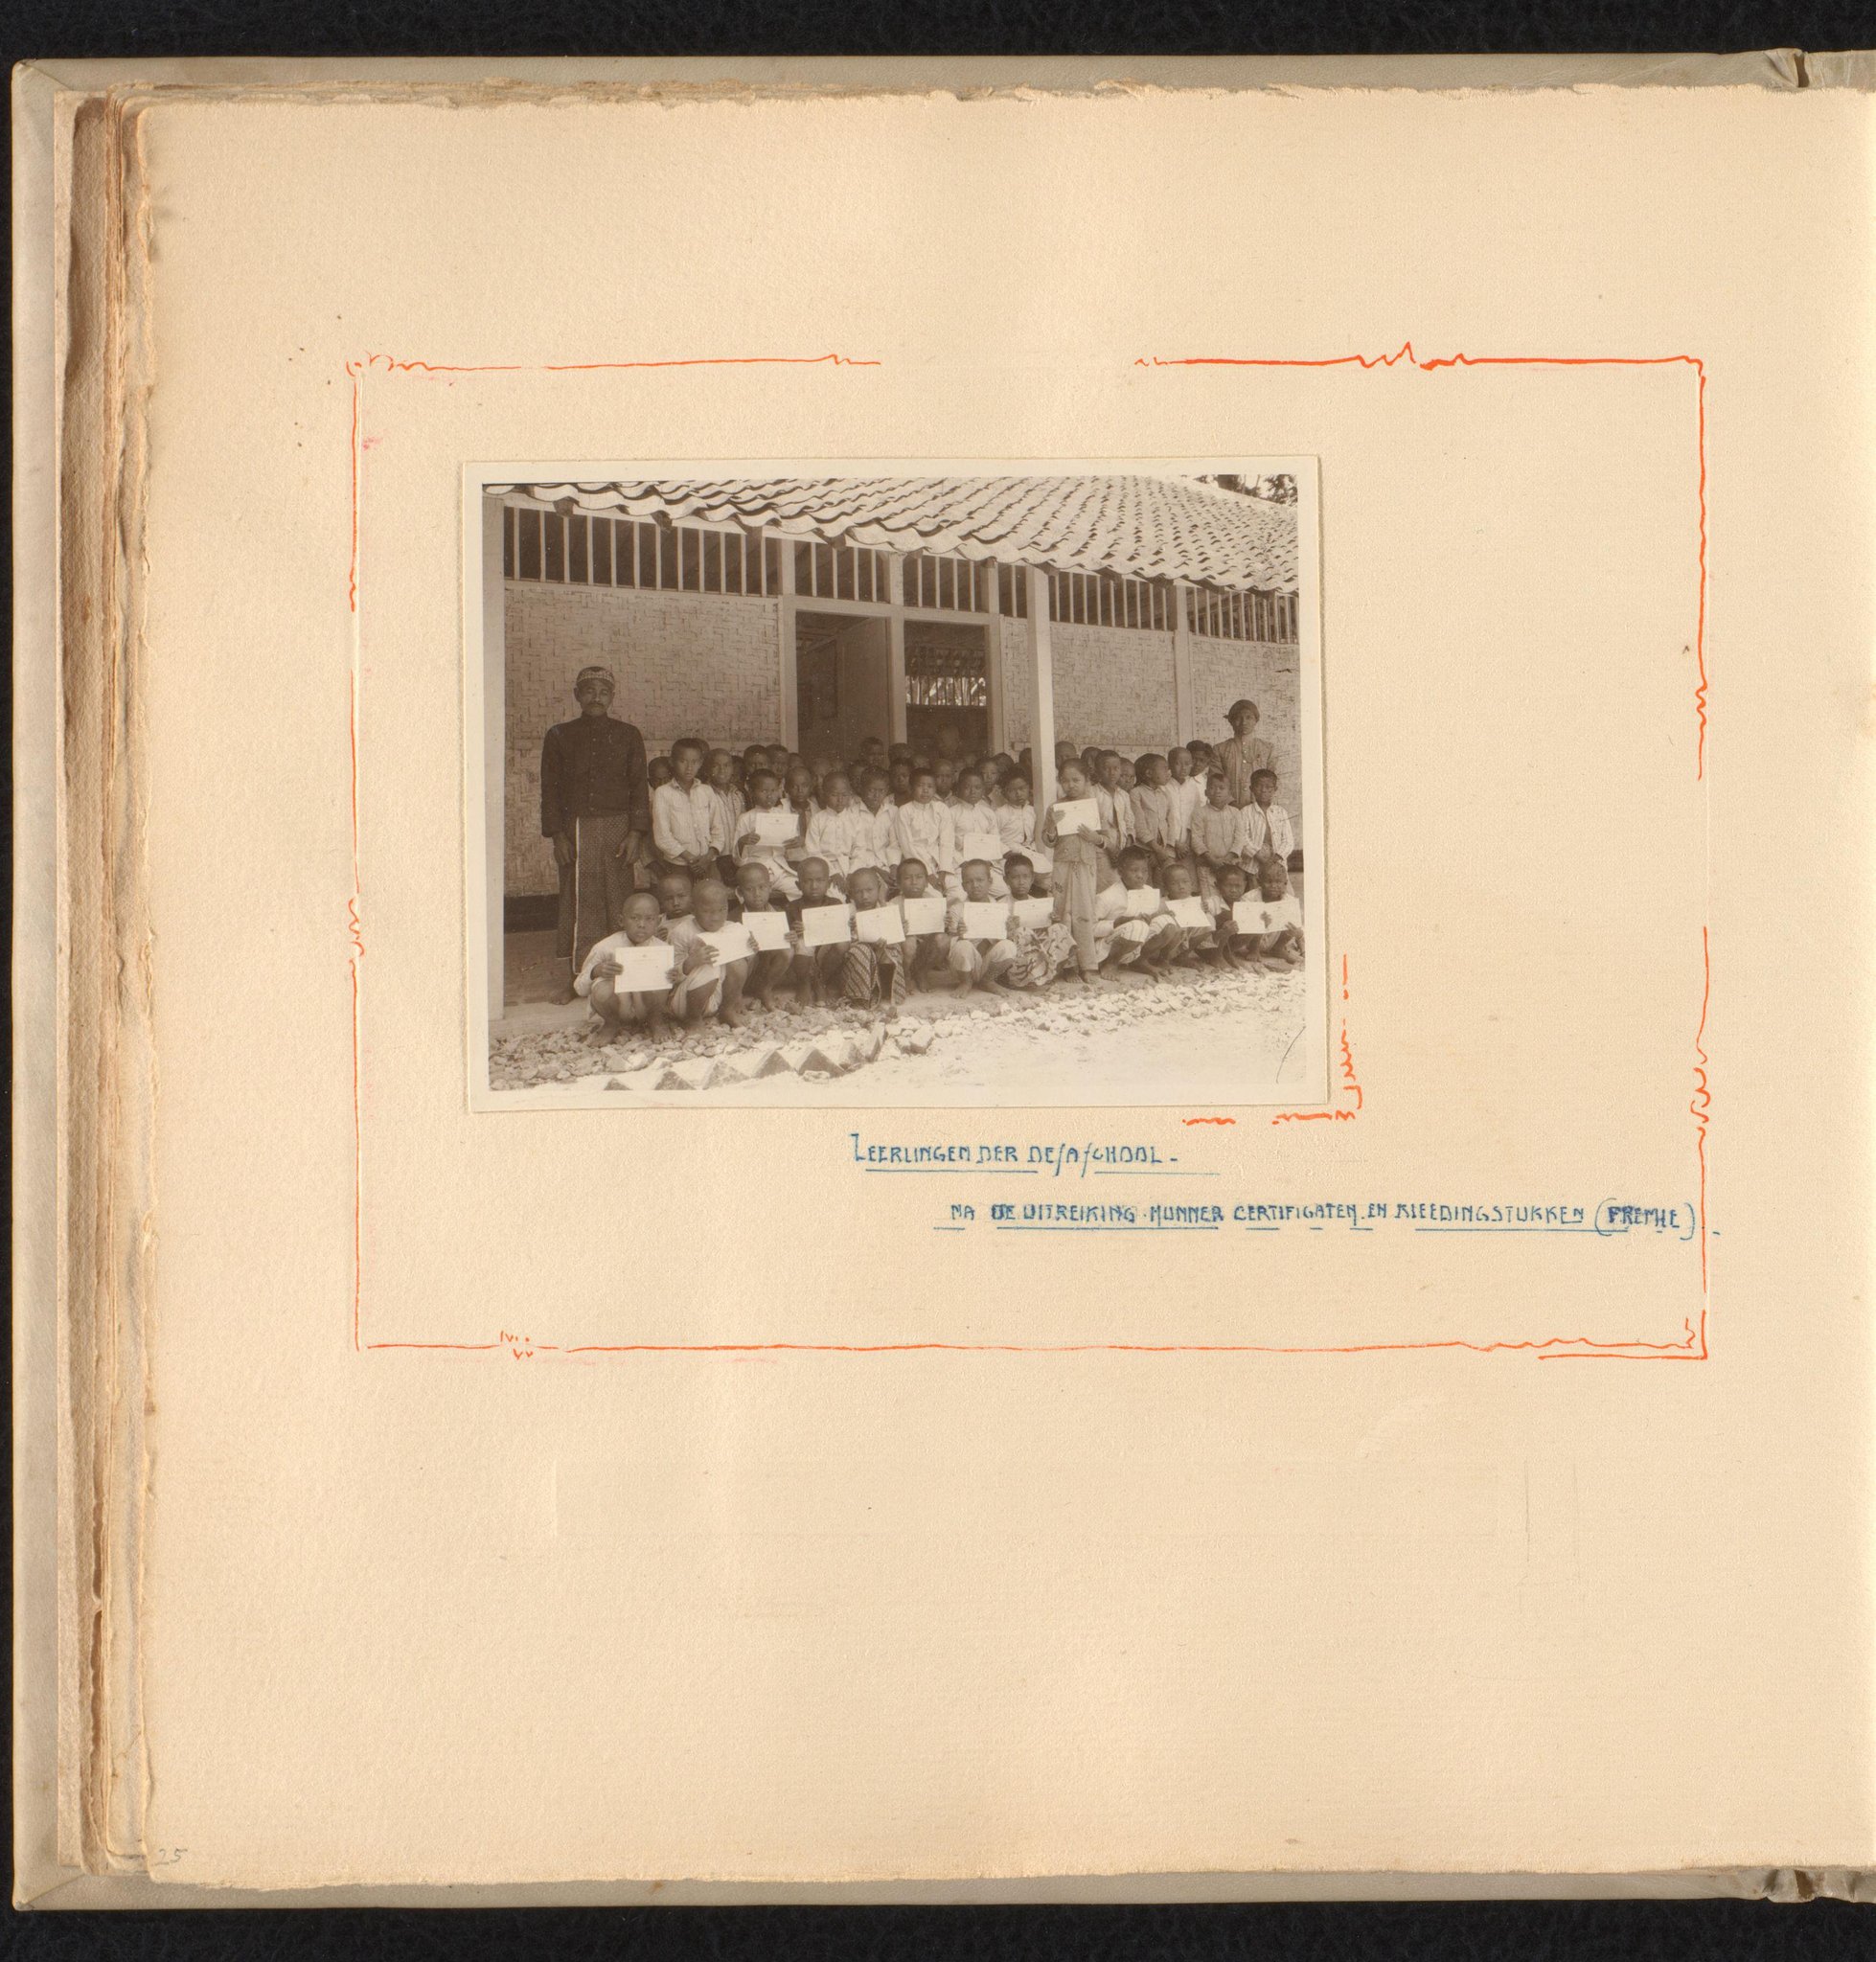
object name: album leaf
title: Leerlingen van een dorpsschool in Grobogan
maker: Anonymous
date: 1910-1928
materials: paper, photographic support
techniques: drawing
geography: grobogan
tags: teacher and pupil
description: Albumblad met een groepsfoto van de leerlinen van een dorpsschool in Grobogan. Het blad is versierd met randwerk om de foto's. Onderdeel van het fotoalbum aangeboden aan J. Habbema door het Binnenlandsch Bestuur Corps van het Regentschap Grobogan, bij het beëindigen van zijn bestuur over het Regentschap, waarschijnlijk in 1928.